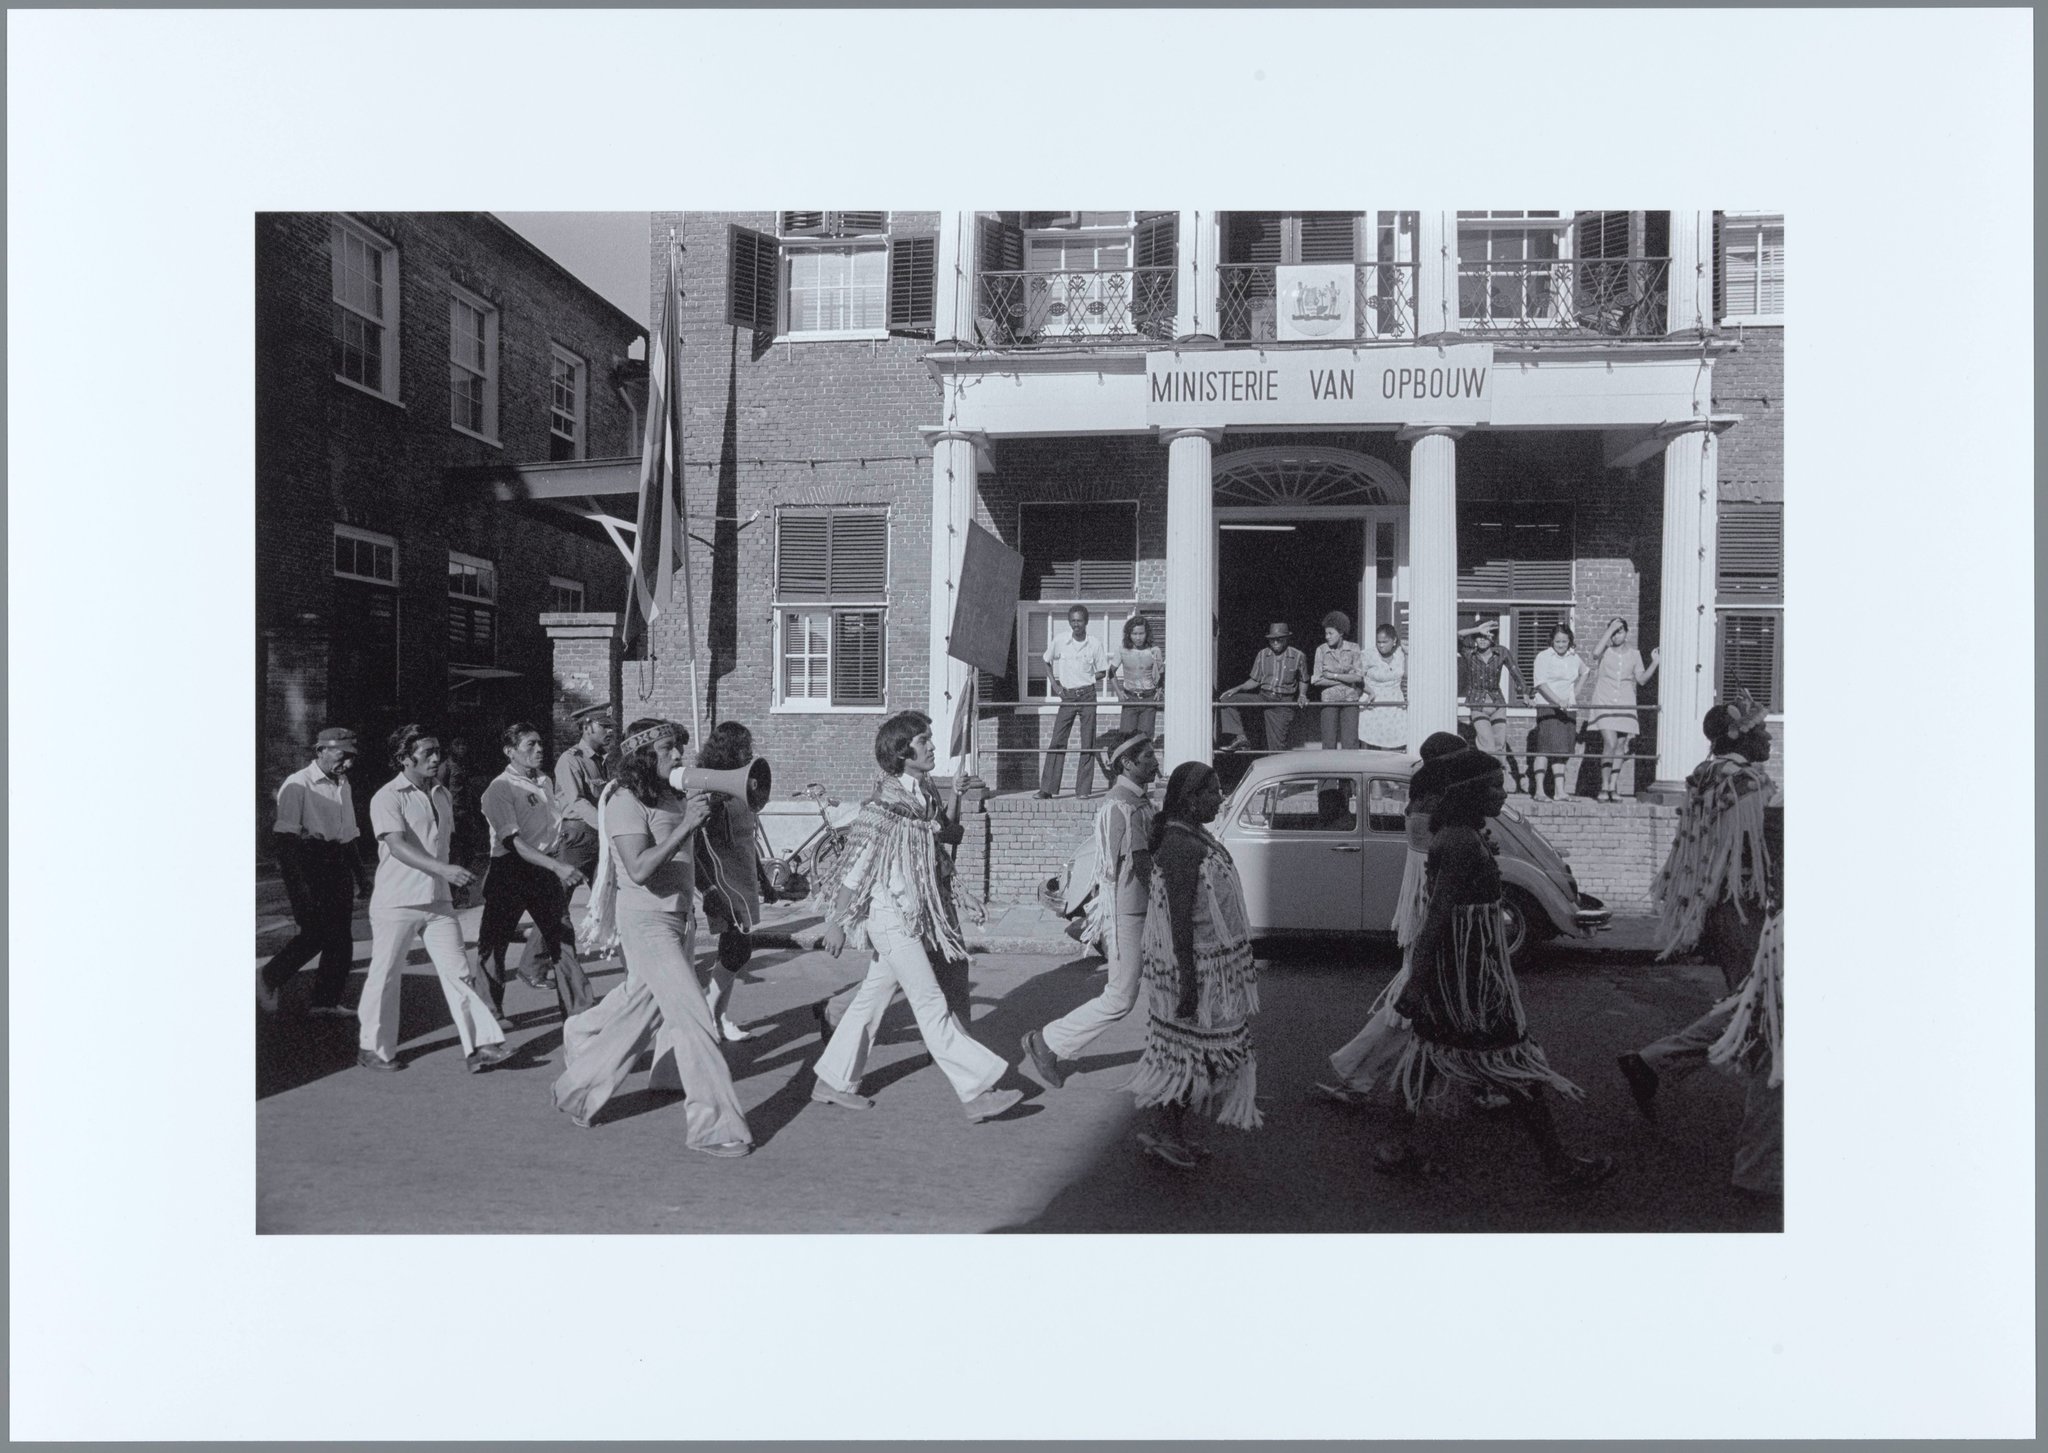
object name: photograph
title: Mars, 30 december 1976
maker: cary markerink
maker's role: fotograaf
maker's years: 1951-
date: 1976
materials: paper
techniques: gelatin silver print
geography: suriname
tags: political demonstration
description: Onderdeel van een serie foto's die een protestmars vastleggen van een groep Caraïben en Arowakken die eind december 1976 in vier dagen van hun woonplaatsen aan de kust via Albina naar Paramaribo liepen. Zij vroegen met hun actie aandacht voor hun grondrechten en de algemene positie van de nazaten van de oorspronkelijke bewoners van Suriname. In Paramaribo werden ze in het presidentieel paleis ontvangen door president J. Ferrier. De fotograaf was bevriend met een van de initiatiefnemers en liep mee met de mars.